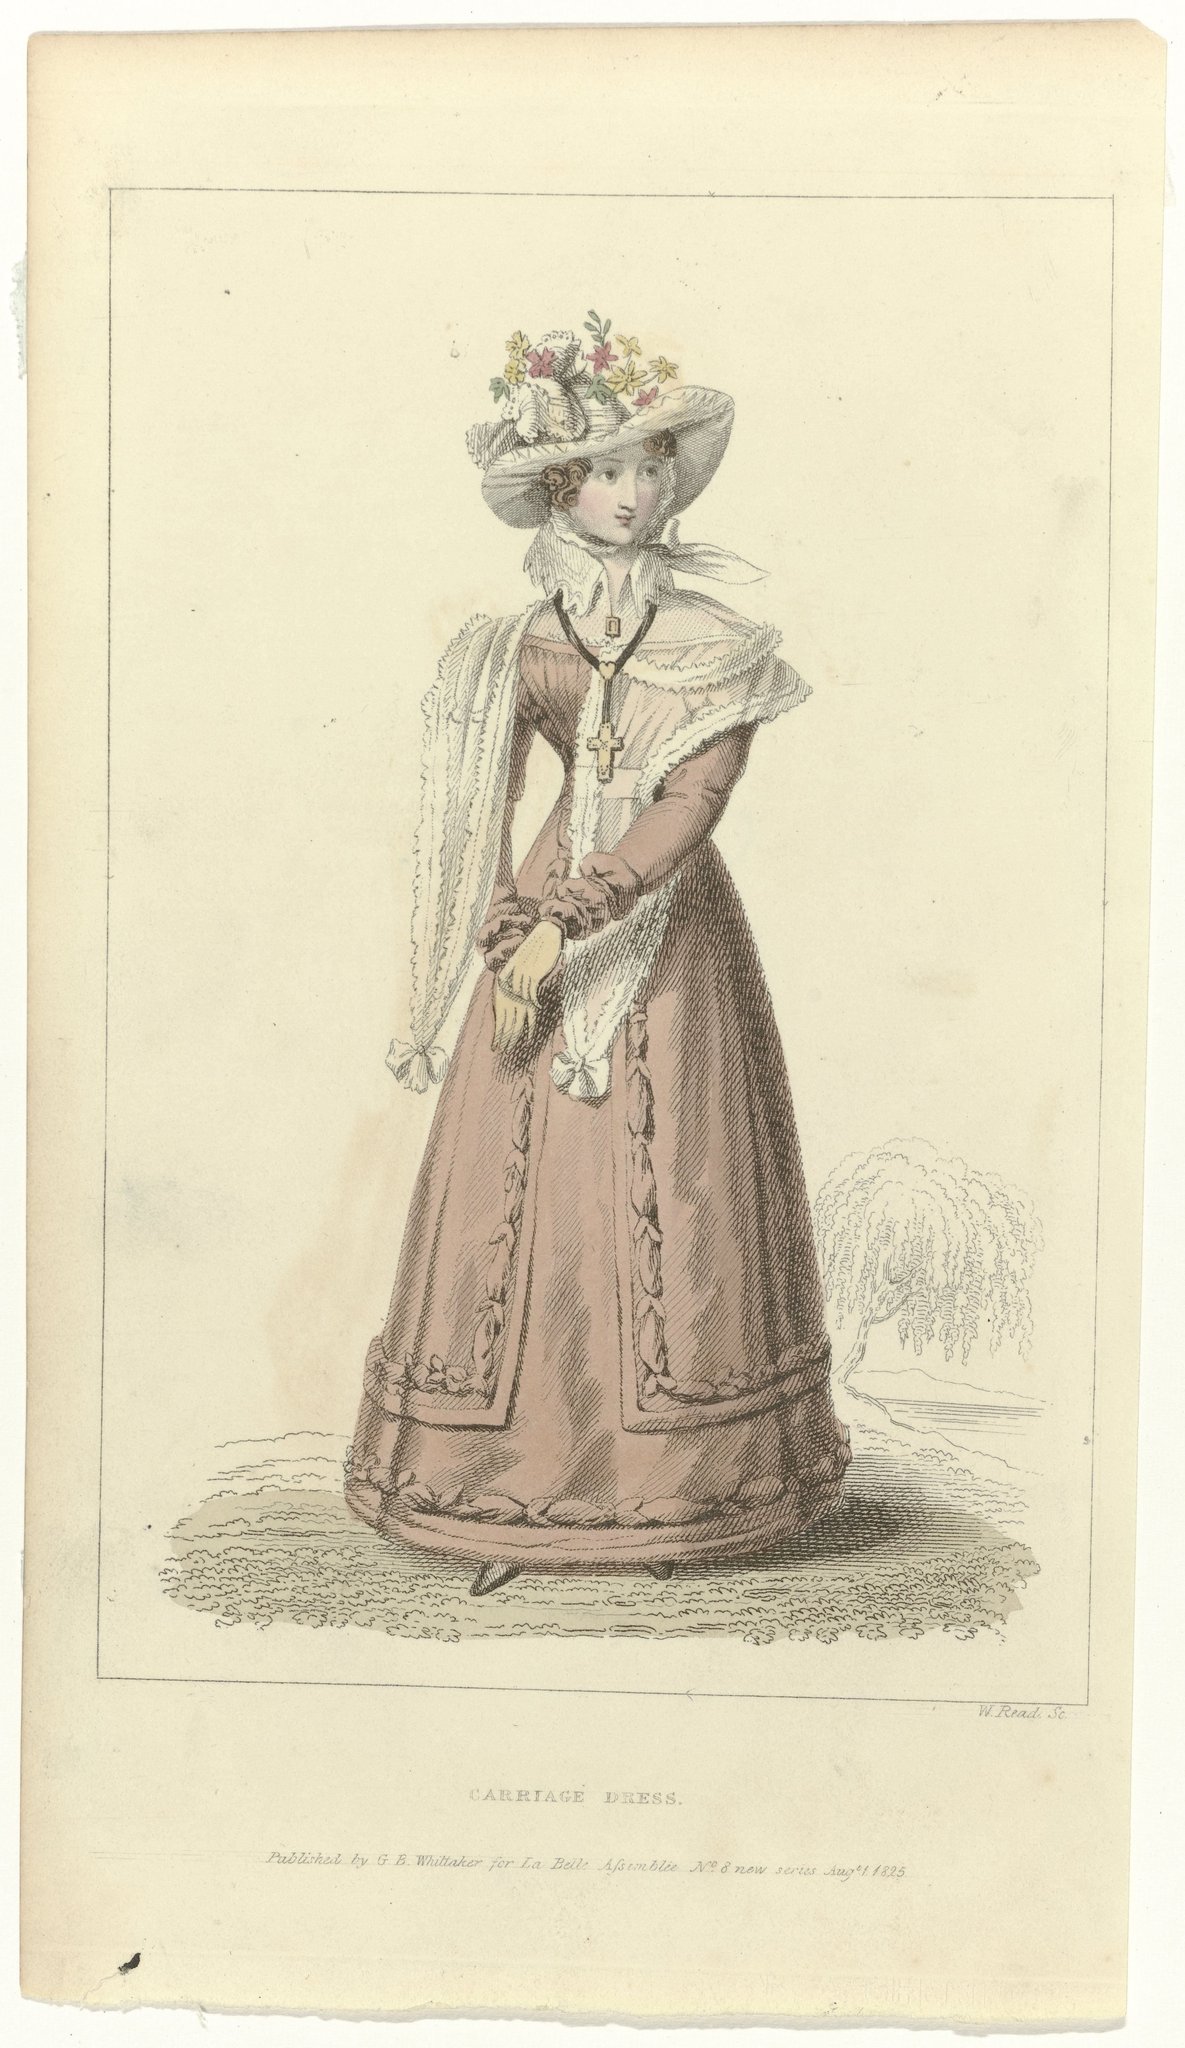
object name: fashion print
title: La Belle Assemblée, 1 august 1825, No. 8 new series: Carriage Dress.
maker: w. read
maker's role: print maker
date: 1825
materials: paper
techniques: etching, hand coloring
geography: london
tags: brooch, agraffe, clasp (+ women's clothes), gloves, mittens (long gloves) (+ women's clothes), piece of clothing covering the breast or décolleté (chemisette) (+ women's clothes), head-gear (+ women's clothes), fashion plates, shoes, sandals (+ women's clothes), dress, gown (+ women's clothes), neck-gear ~ clothing (+ women's clothes), necklace (+ women's clothes)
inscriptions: caption: ‘Published by G.B. Whittaker for La Belle Assemblée No. 8 new series Aug.t 1 1825.’, title: ‘Carriage Dress’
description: 'Carriage dress' met lange mouwen. 'Chemisette'(?) of kraag. Kleine schoudermantel(?) met slippen. Accessoires: hoed versierd met bloemen, broche, collier met een hanger in de vorm van een kruis, handschoenen. Prent uit het modetijdschrift La Belle Assemblée, or Bell's Court and Fashionable Magazine Addressed Particularly to the Ladies (1806-1832).